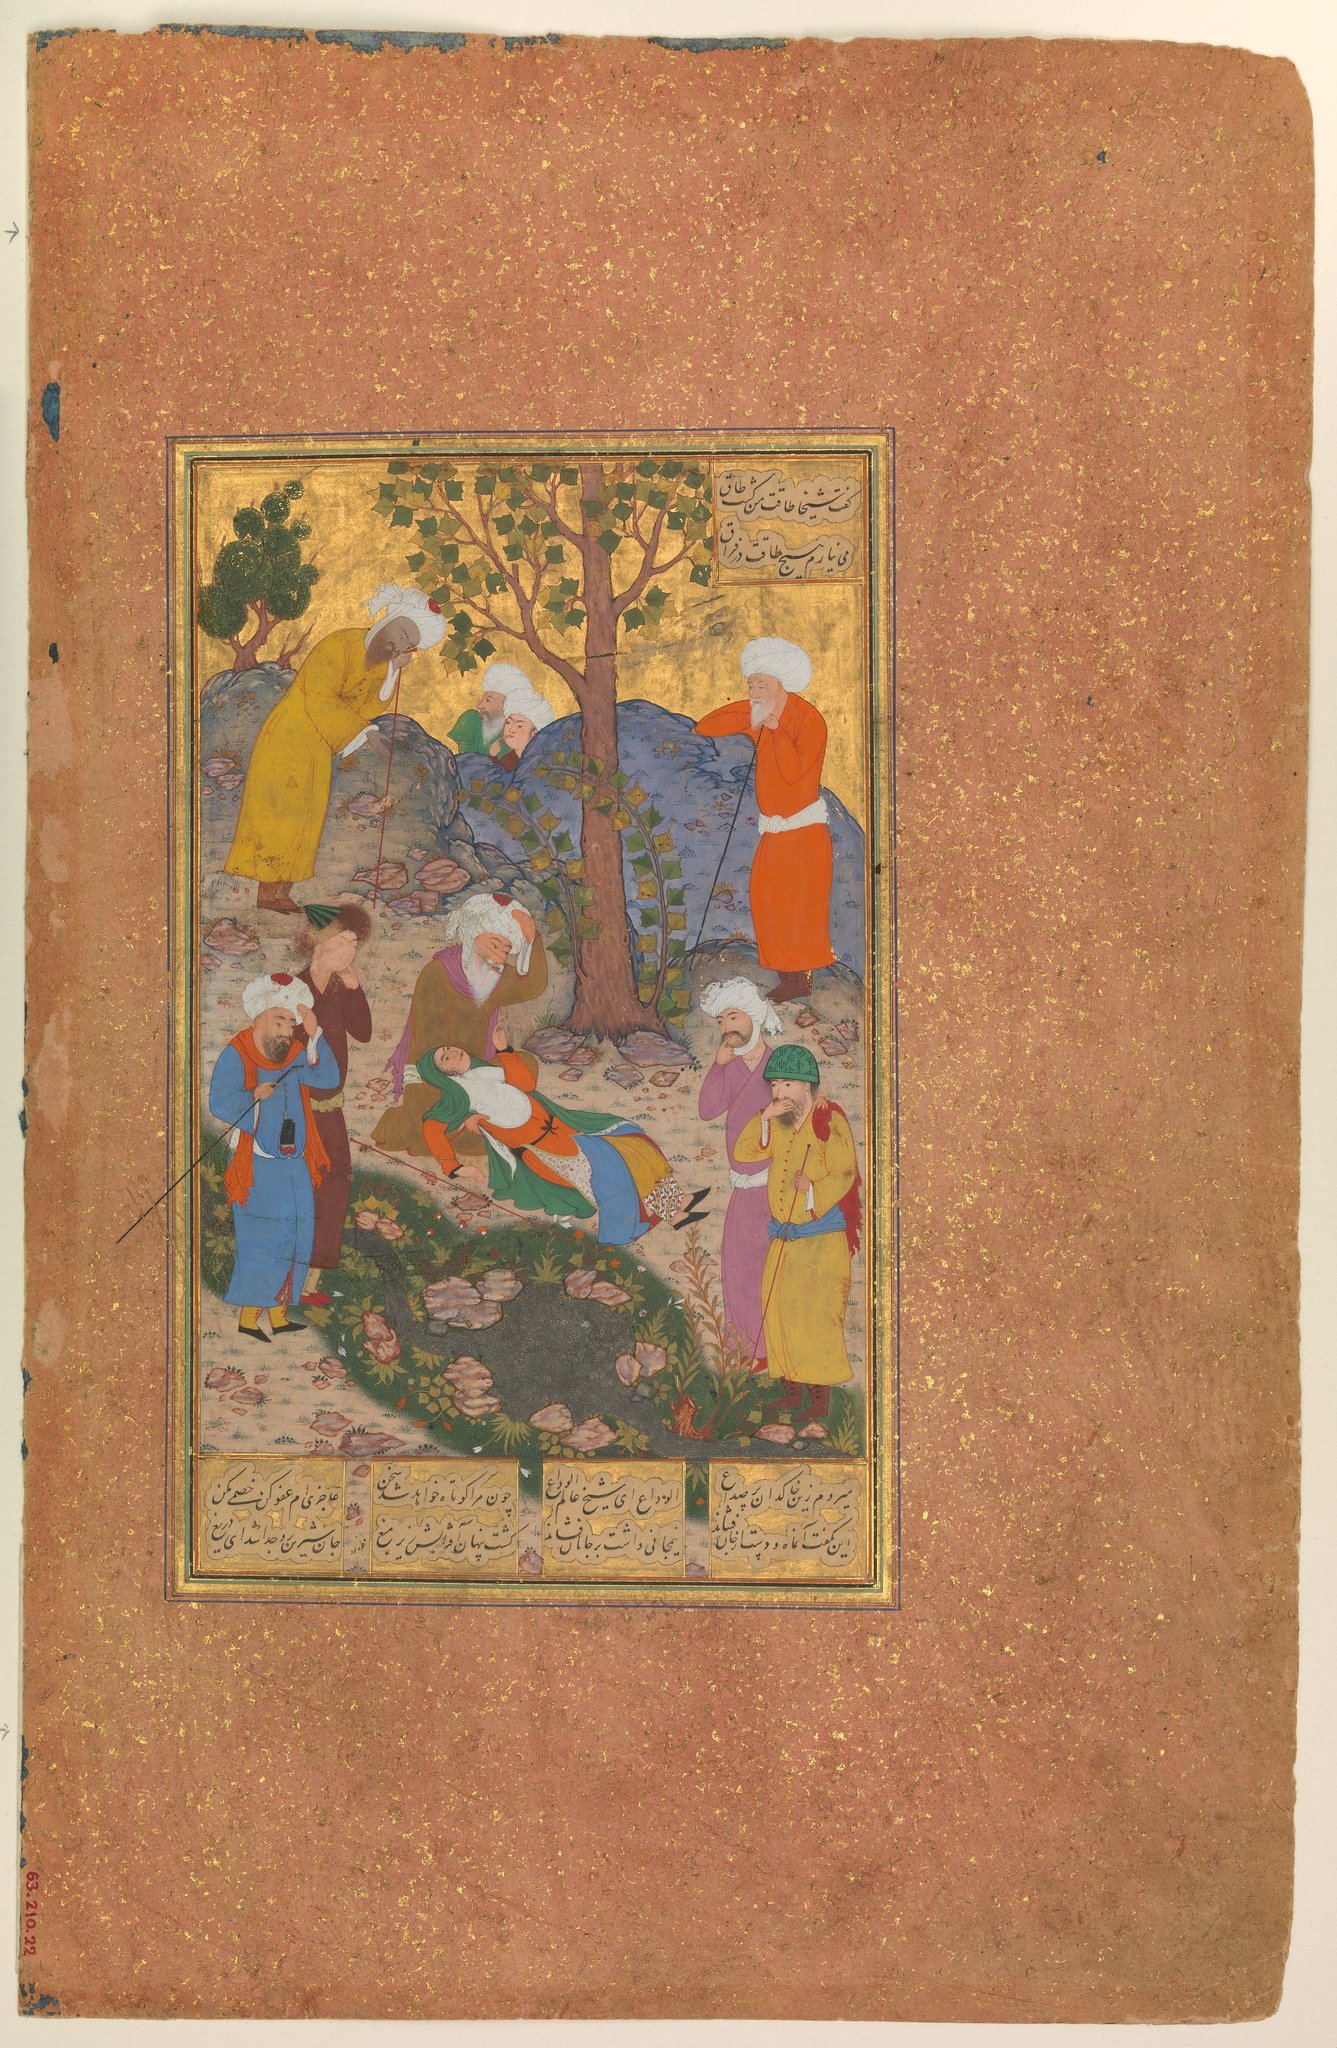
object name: folio from an illustrated manuscript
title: "Shaikh San'an and the Christian Maiden", Folio 22v from a Mantiq al-Tayr (Language of the Birds)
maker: farid al-din `attar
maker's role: author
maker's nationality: iranian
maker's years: 1142-1220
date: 1600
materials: gold, paper, silver, watercolor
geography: iran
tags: men,women